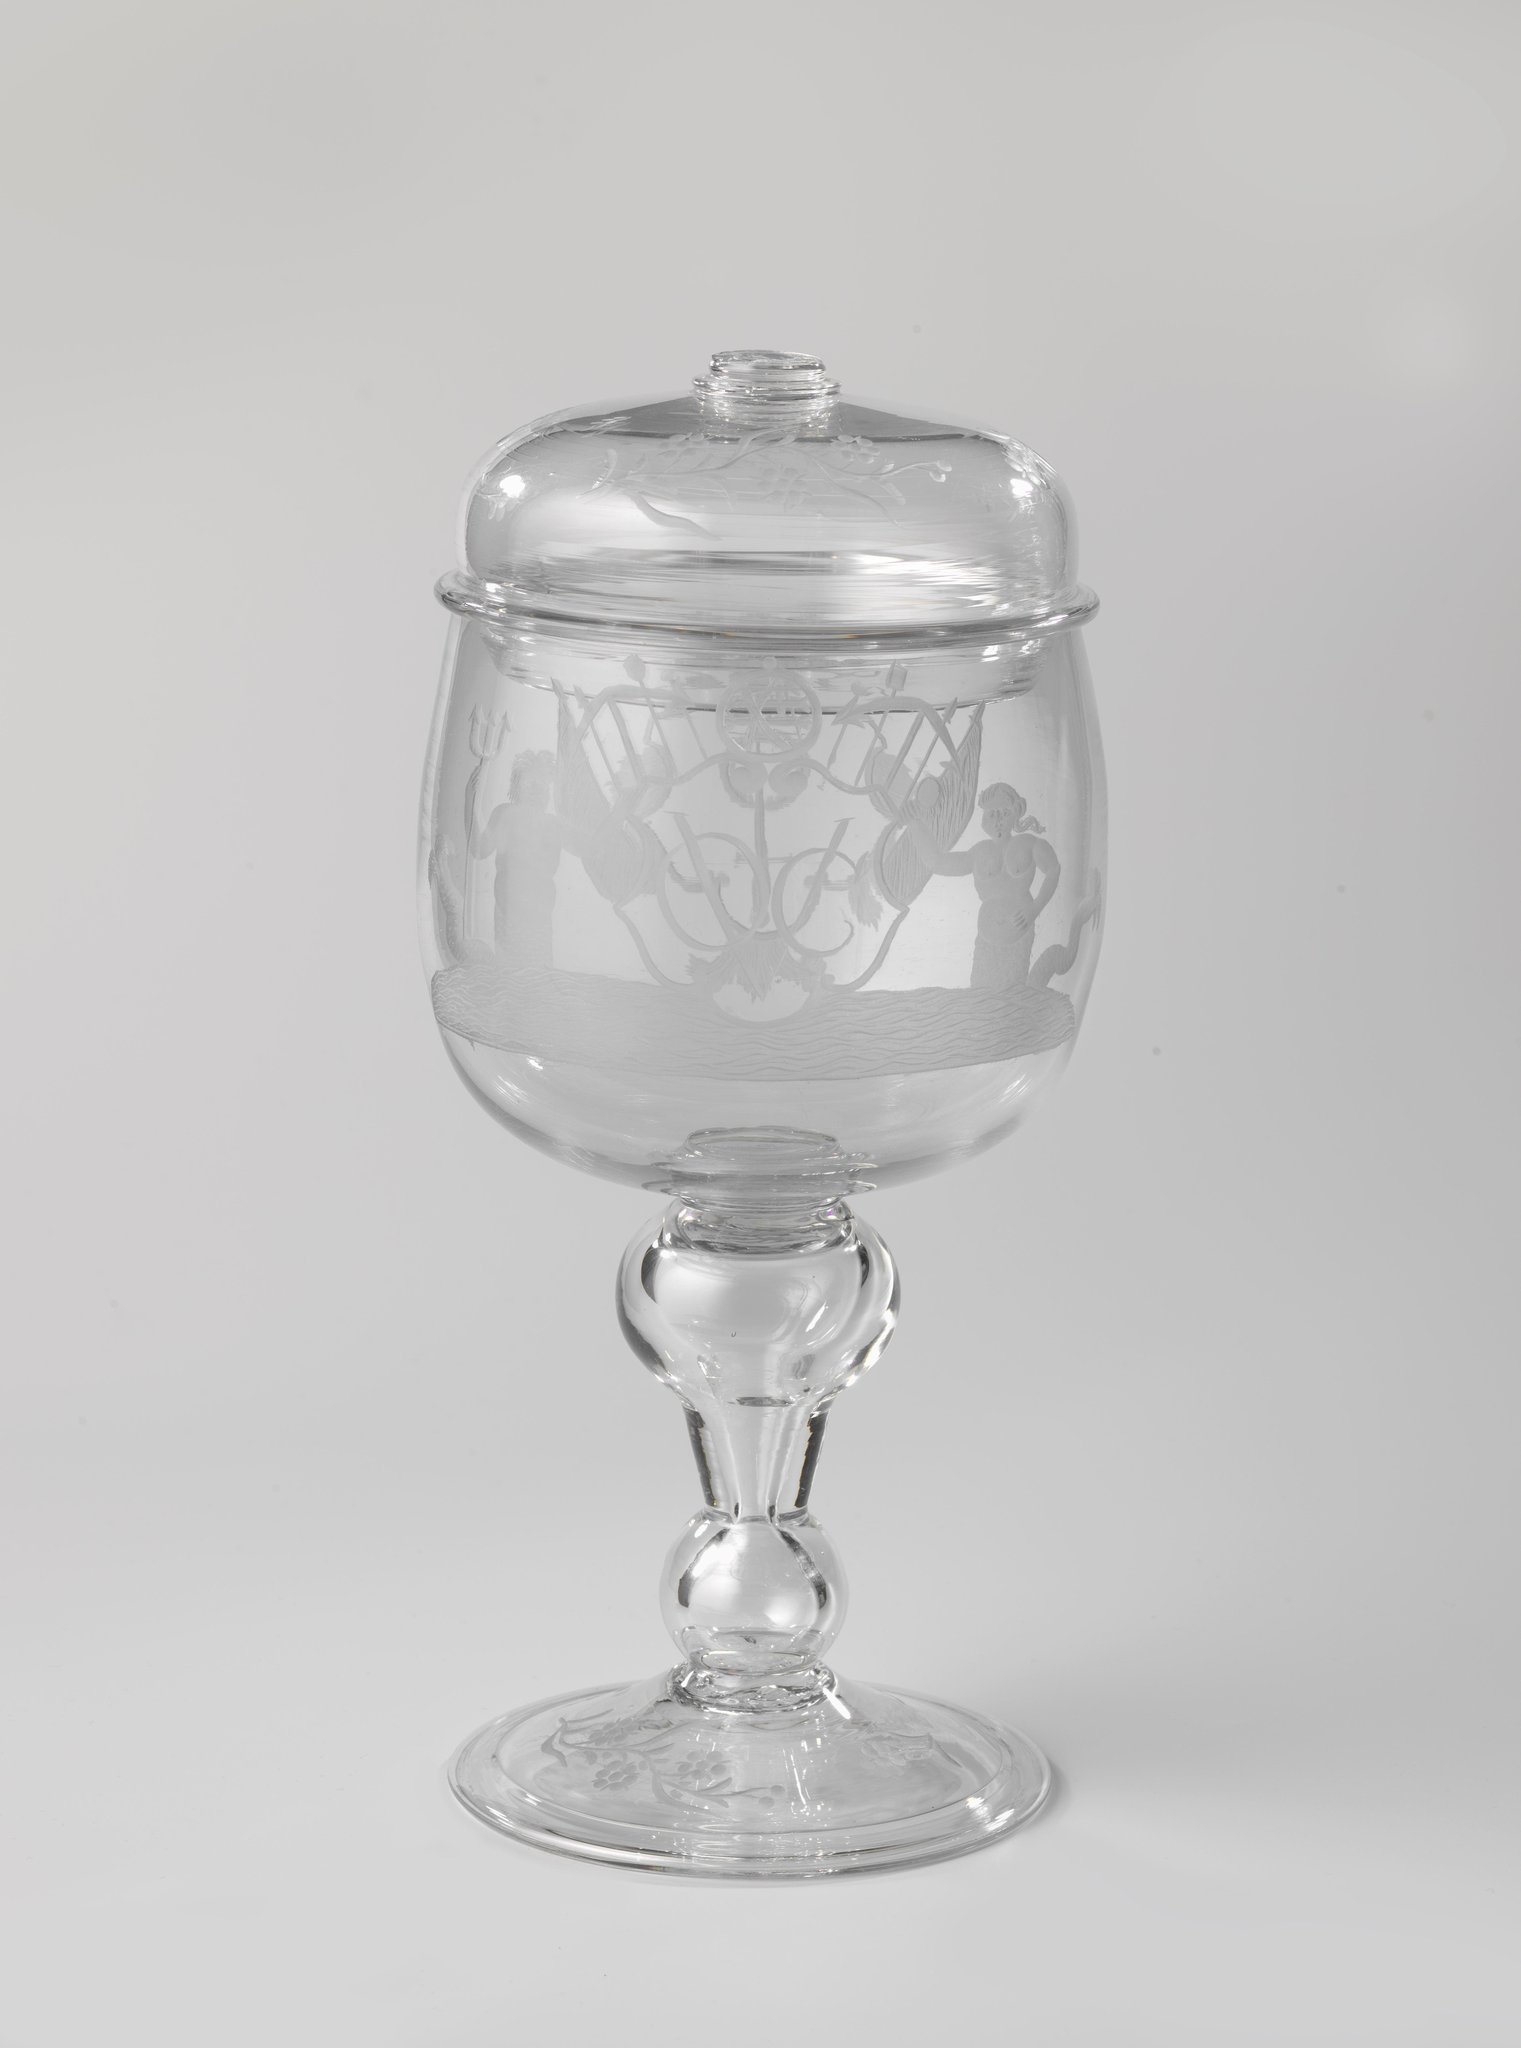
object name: goblet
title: Bokaal met het wapen van Batavia en het VOC-monogram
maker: Anonymous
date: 1700-1725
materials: glass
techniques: glassblowing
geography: northern netherlands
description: Gewelfde voet met omgeslagen rand. Holle balusterstam met een knop. Op de tulpvormige kelk het VOC-monogram in een schild tussen Neptunus en zeemeermin, benevens het wapen van Batavia. Voet met bladornament.